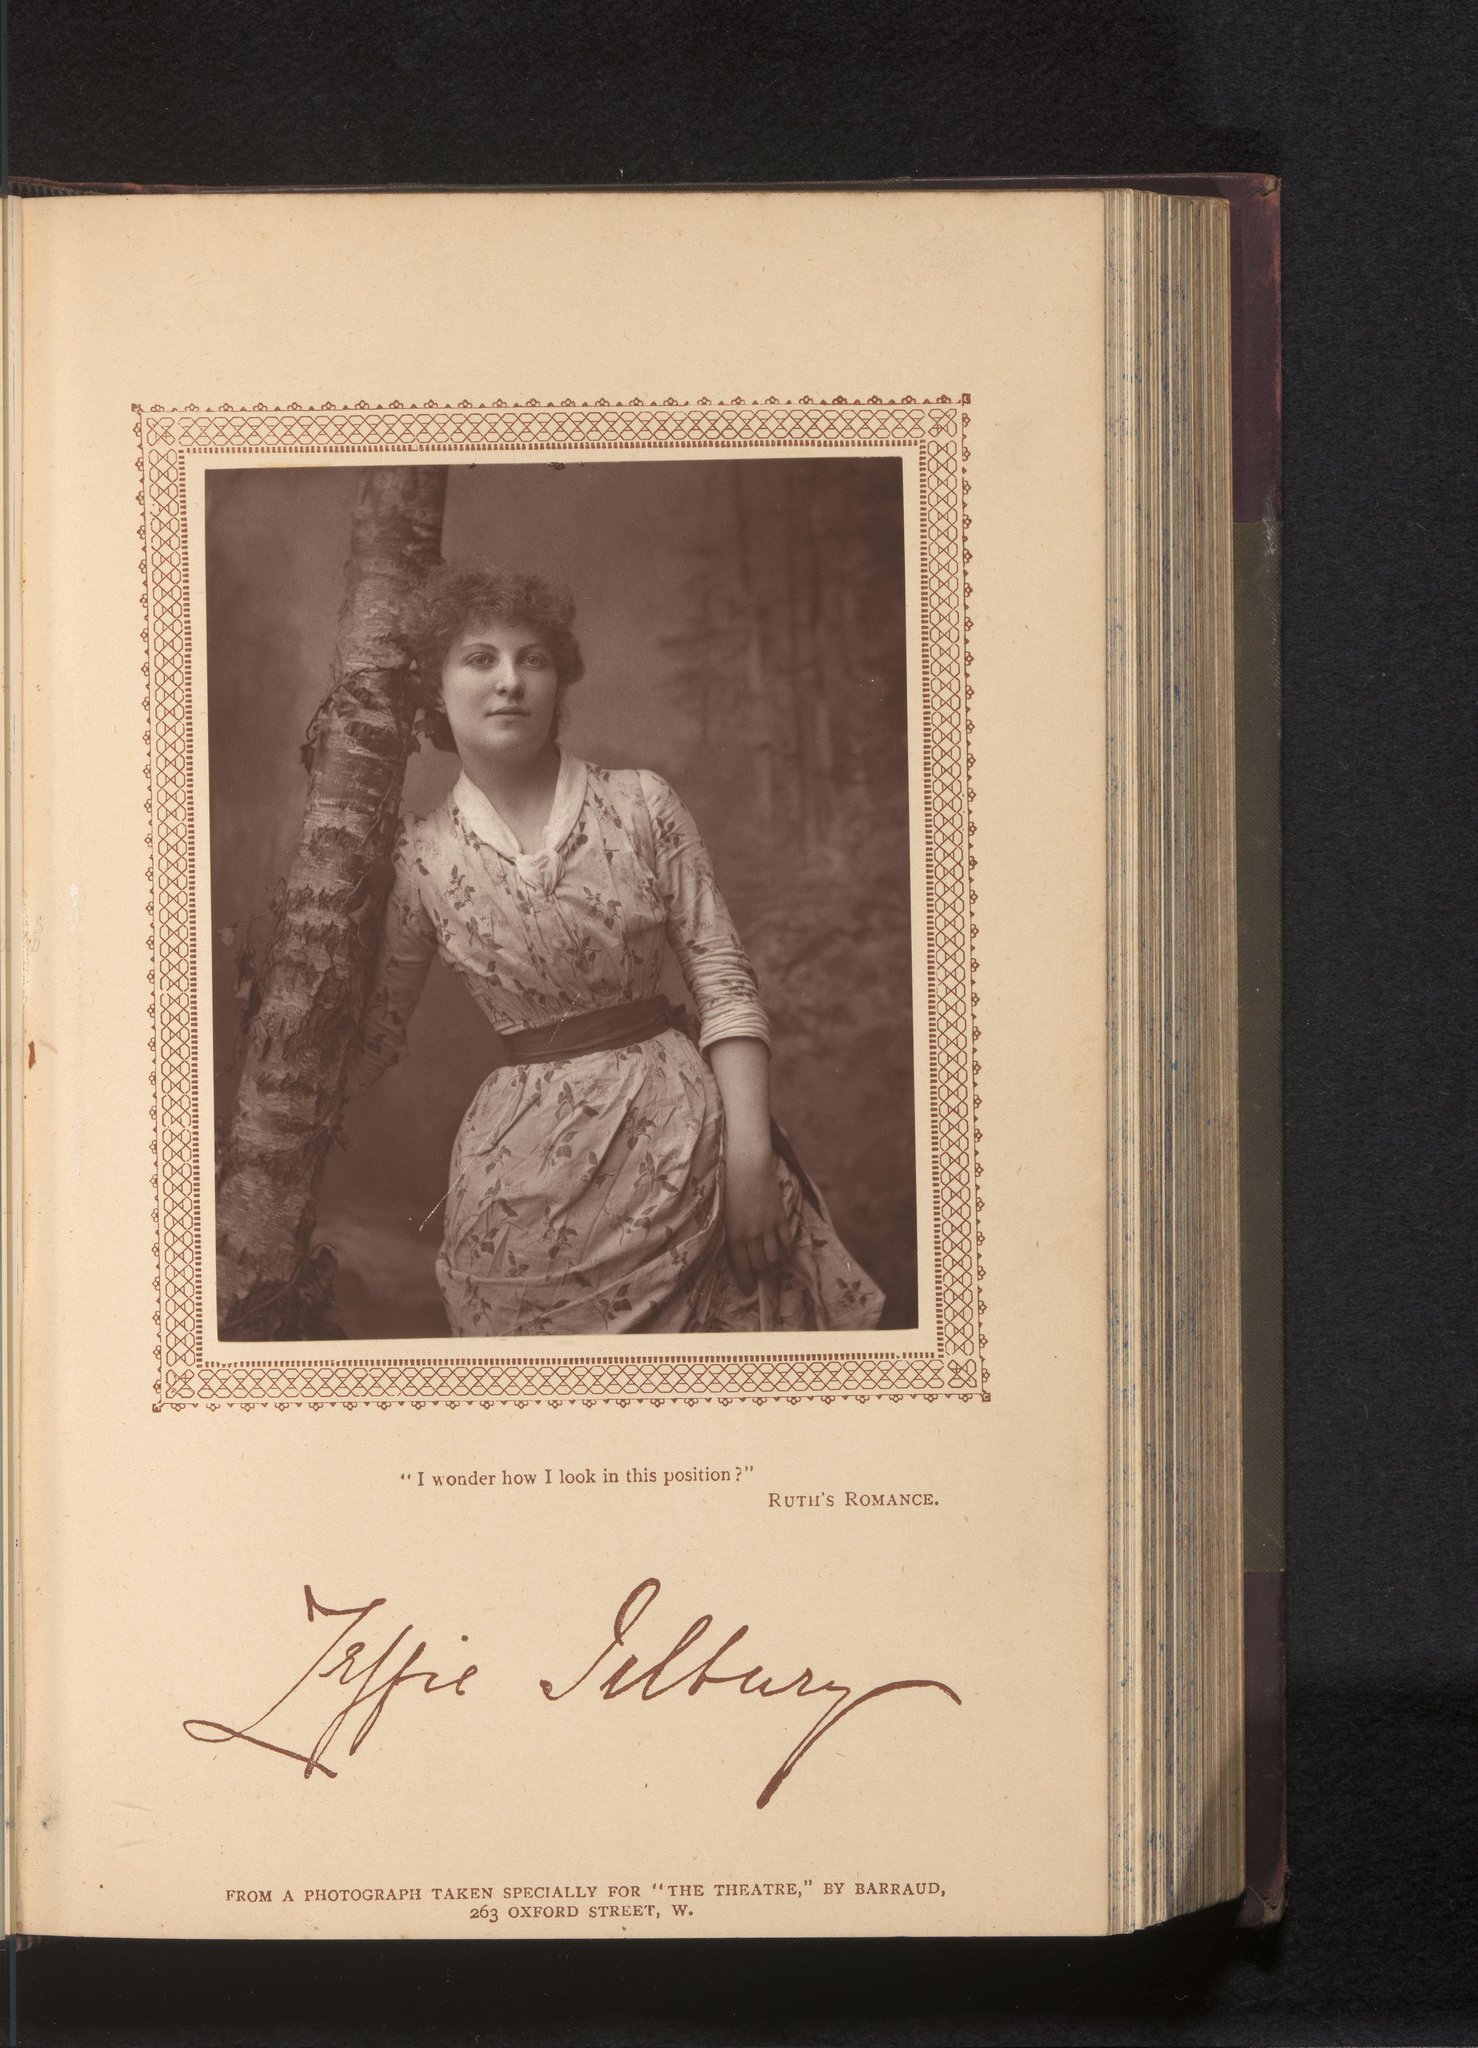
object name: photomechanical print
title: Portret van Miss Tilbury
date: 1880-1885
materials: paper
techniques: woodburytype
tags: adult woman, historical persons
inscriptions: signature: ‘[...] Tilbury’, inscription: ‘'I wonder how I look in this position?'/ Ruth's Romance’